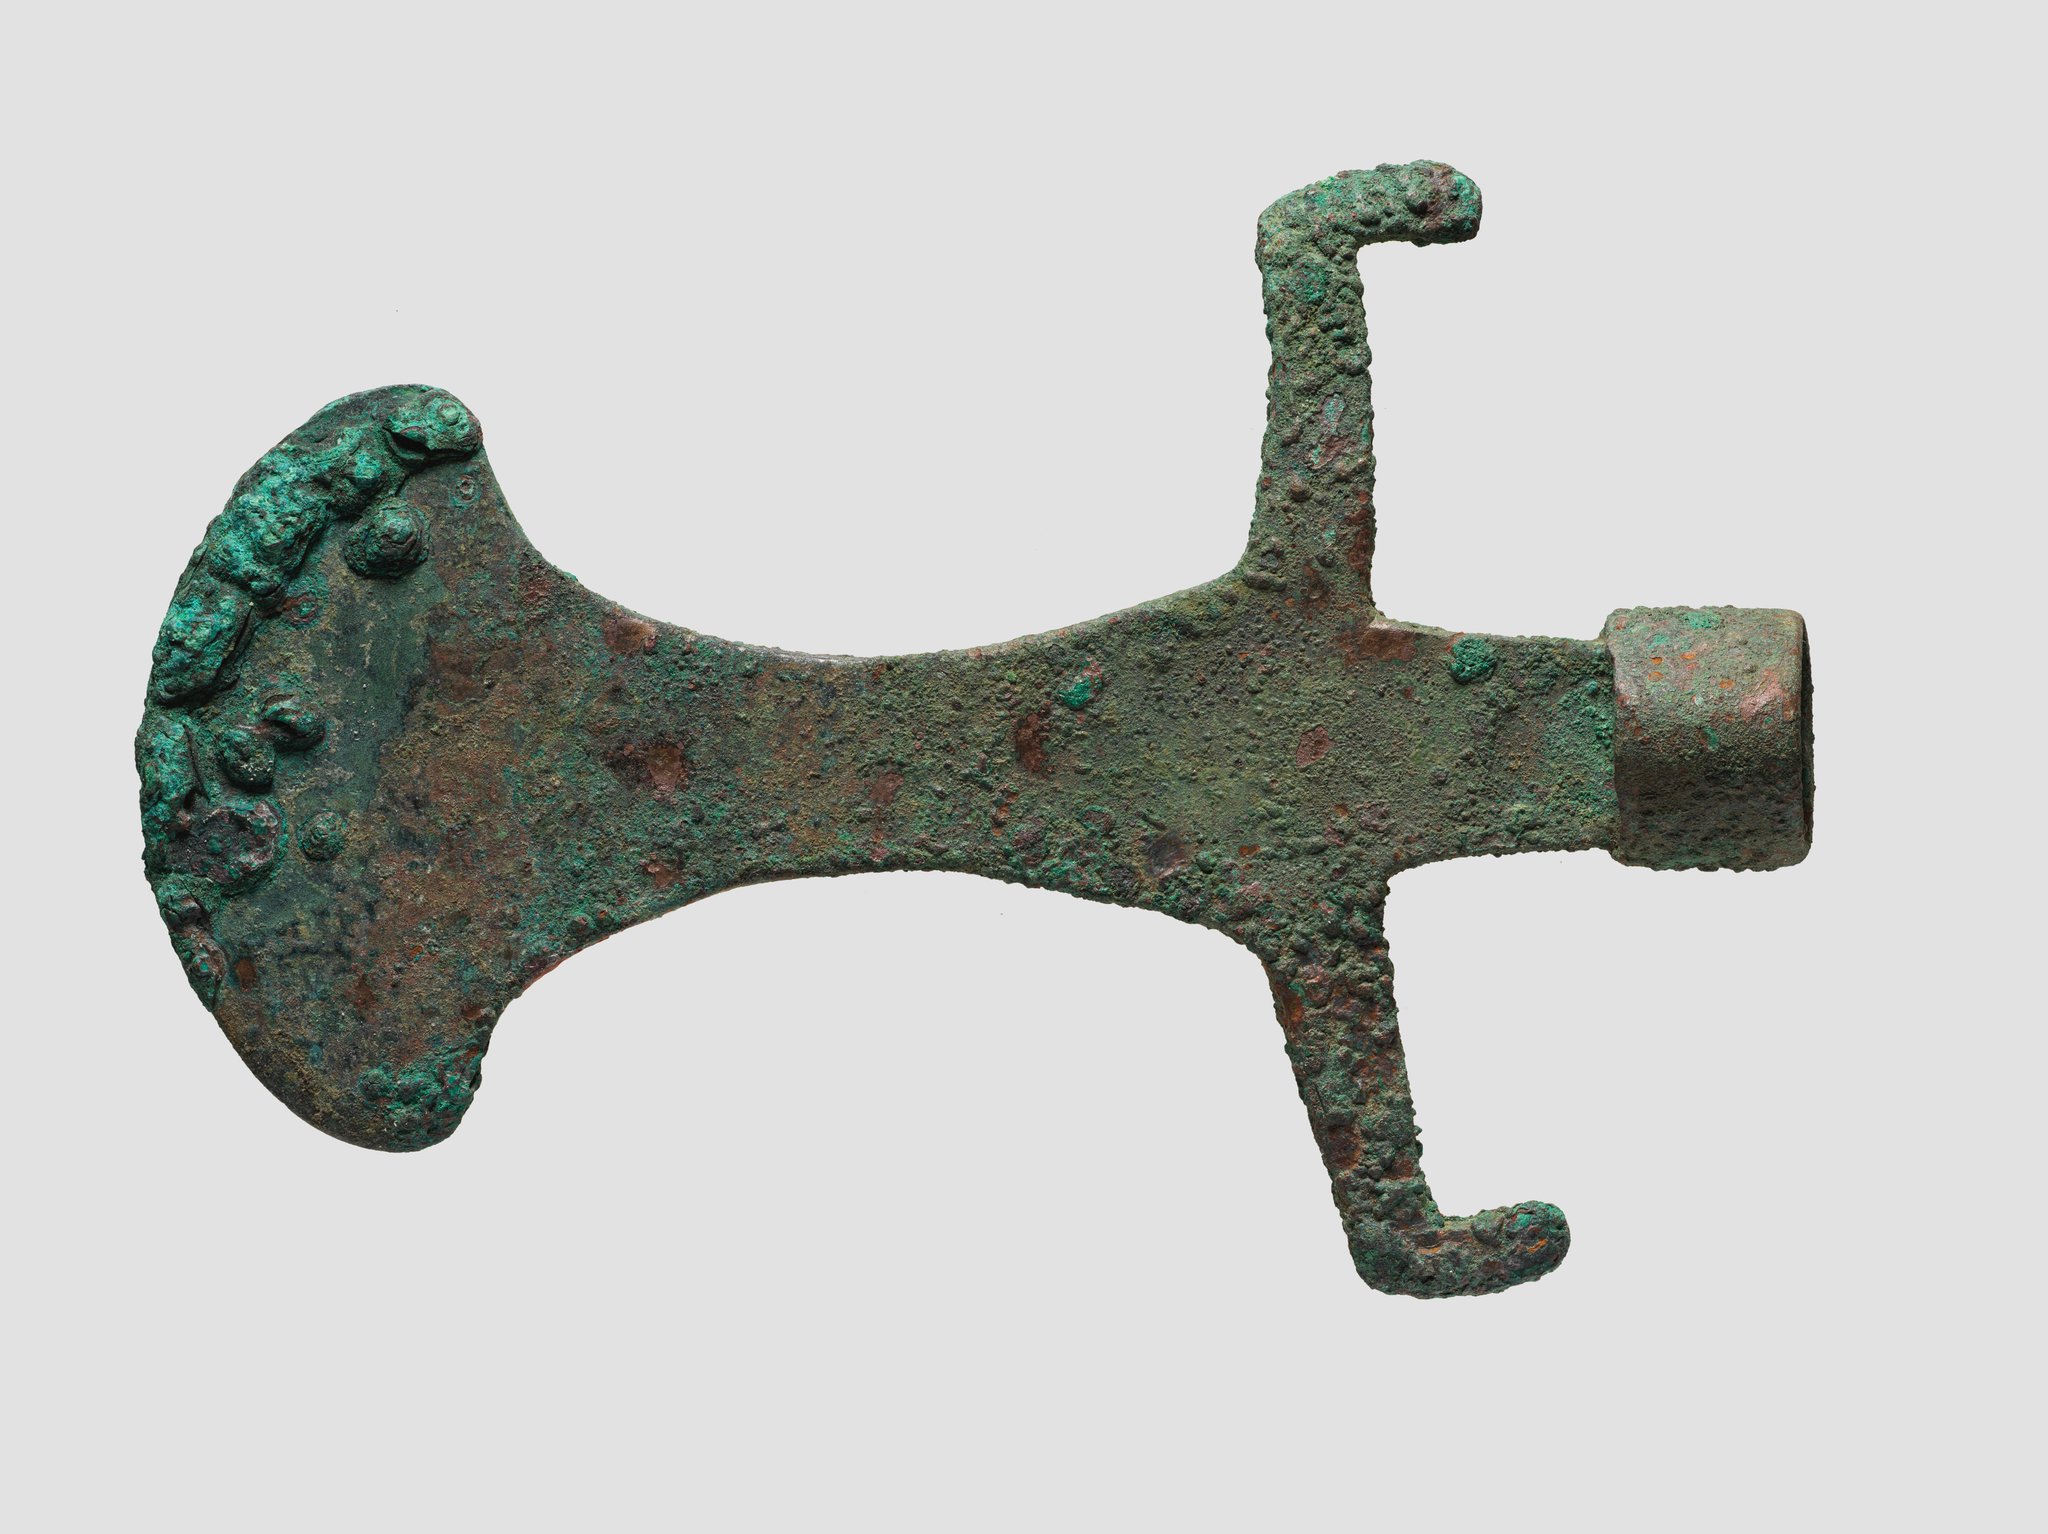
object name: axe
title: Axe blade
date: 1000-668 BCE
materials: bronze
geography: transcaucasia